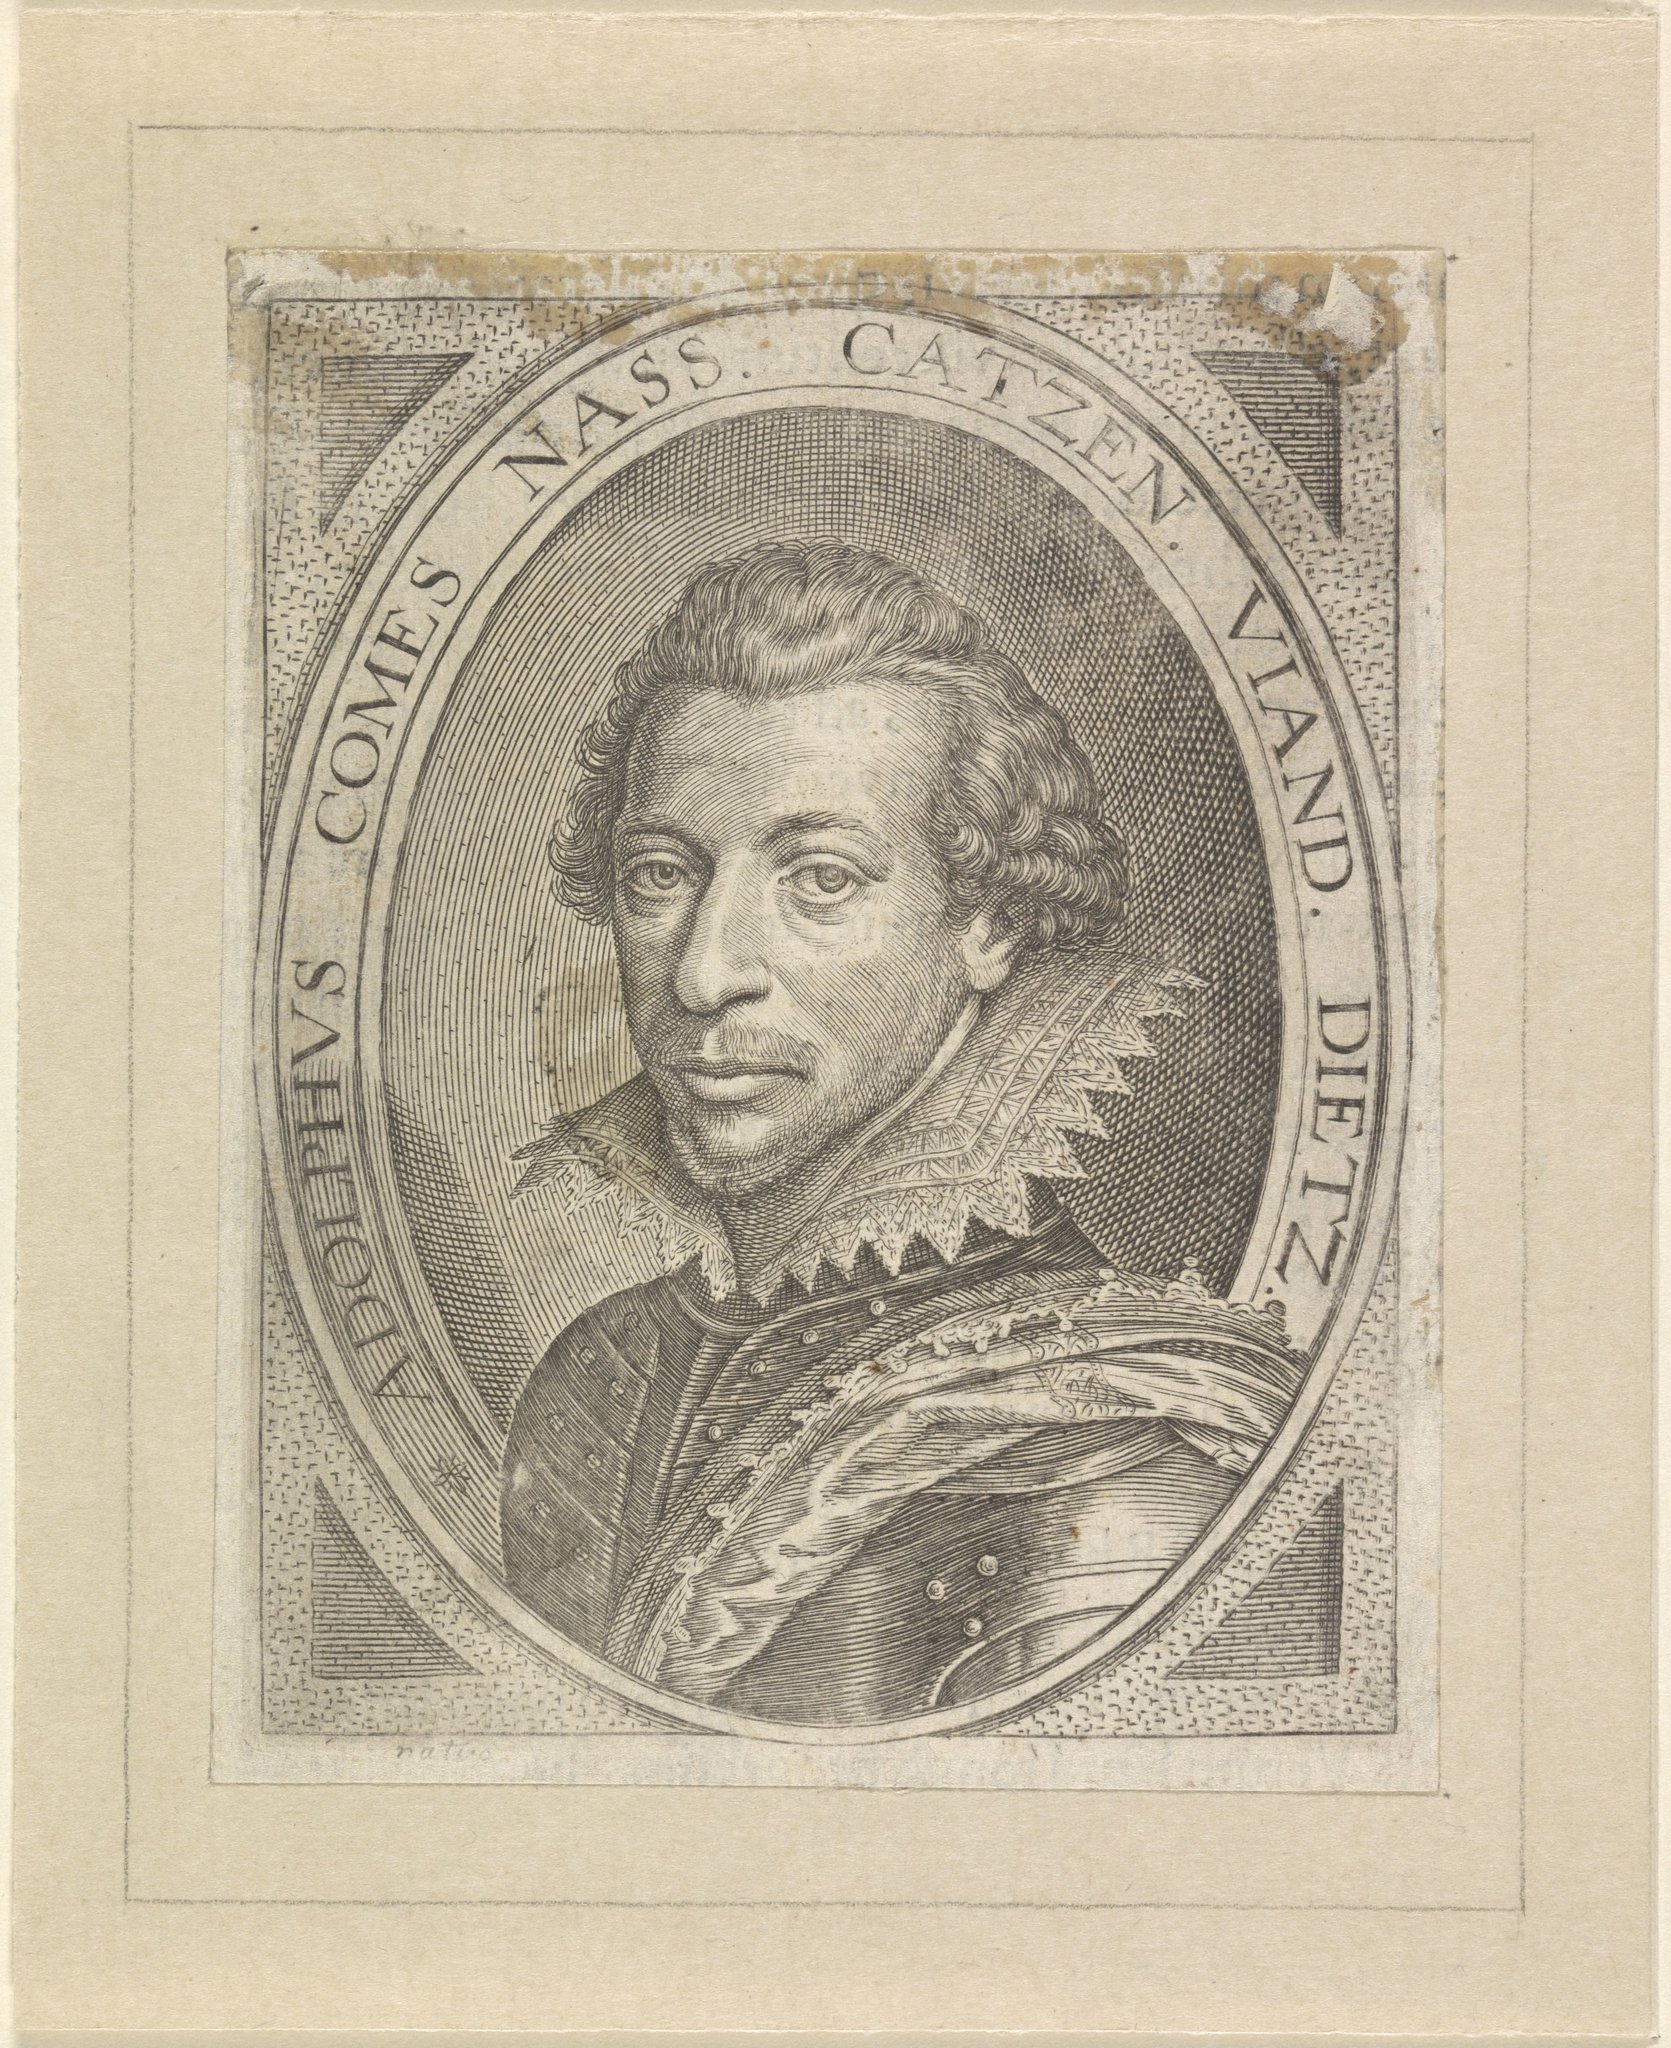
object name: print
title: Portret van Adolf, graaf van Nassau-Siegen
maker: Anonymous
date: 1600-1699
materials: paper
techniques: engraving, etching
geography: low countries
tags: earl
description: De hier vermelde titel verwijst naar de hoogst verkregen titel van de geportretteerde, niet per se naar de titel die de geportretteerde op deze voorstelling draagt.